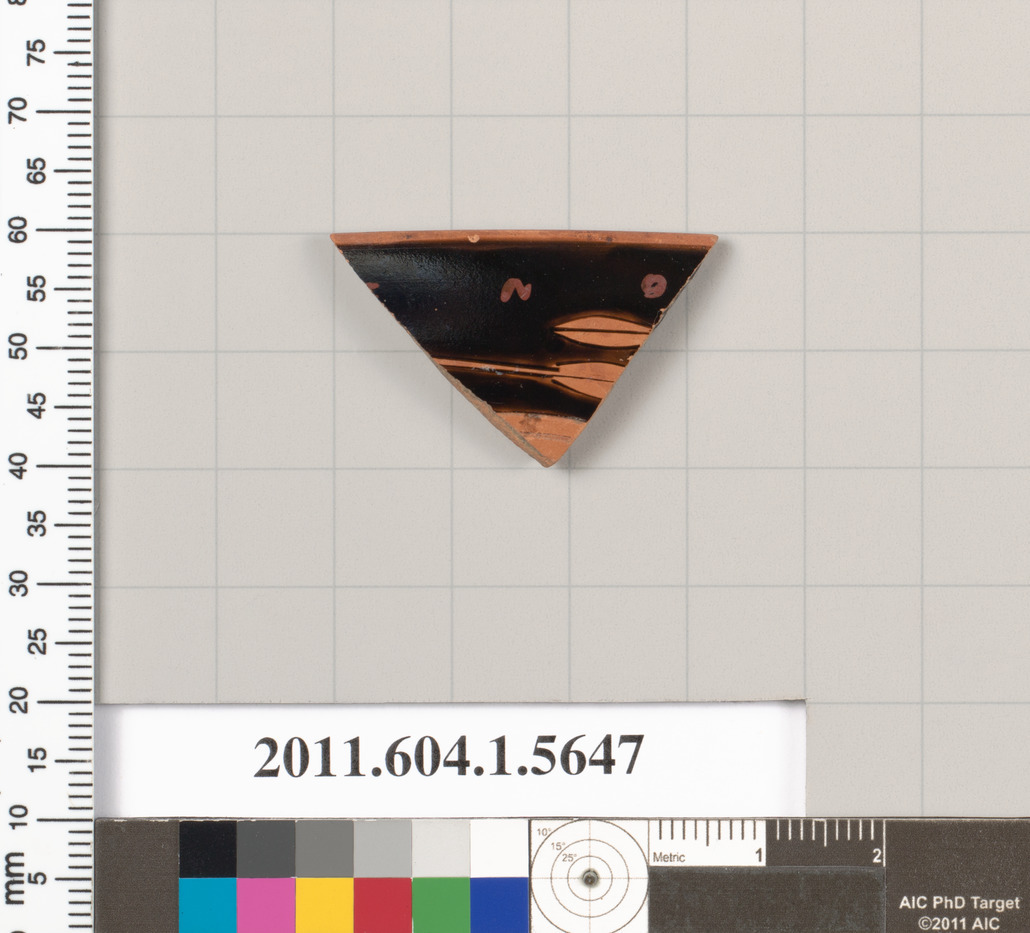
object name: kylix fragment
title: Terracotta rim fragment of a kylix (drinking cup)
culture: greek, attic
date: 510-490 BCE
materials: terracotta